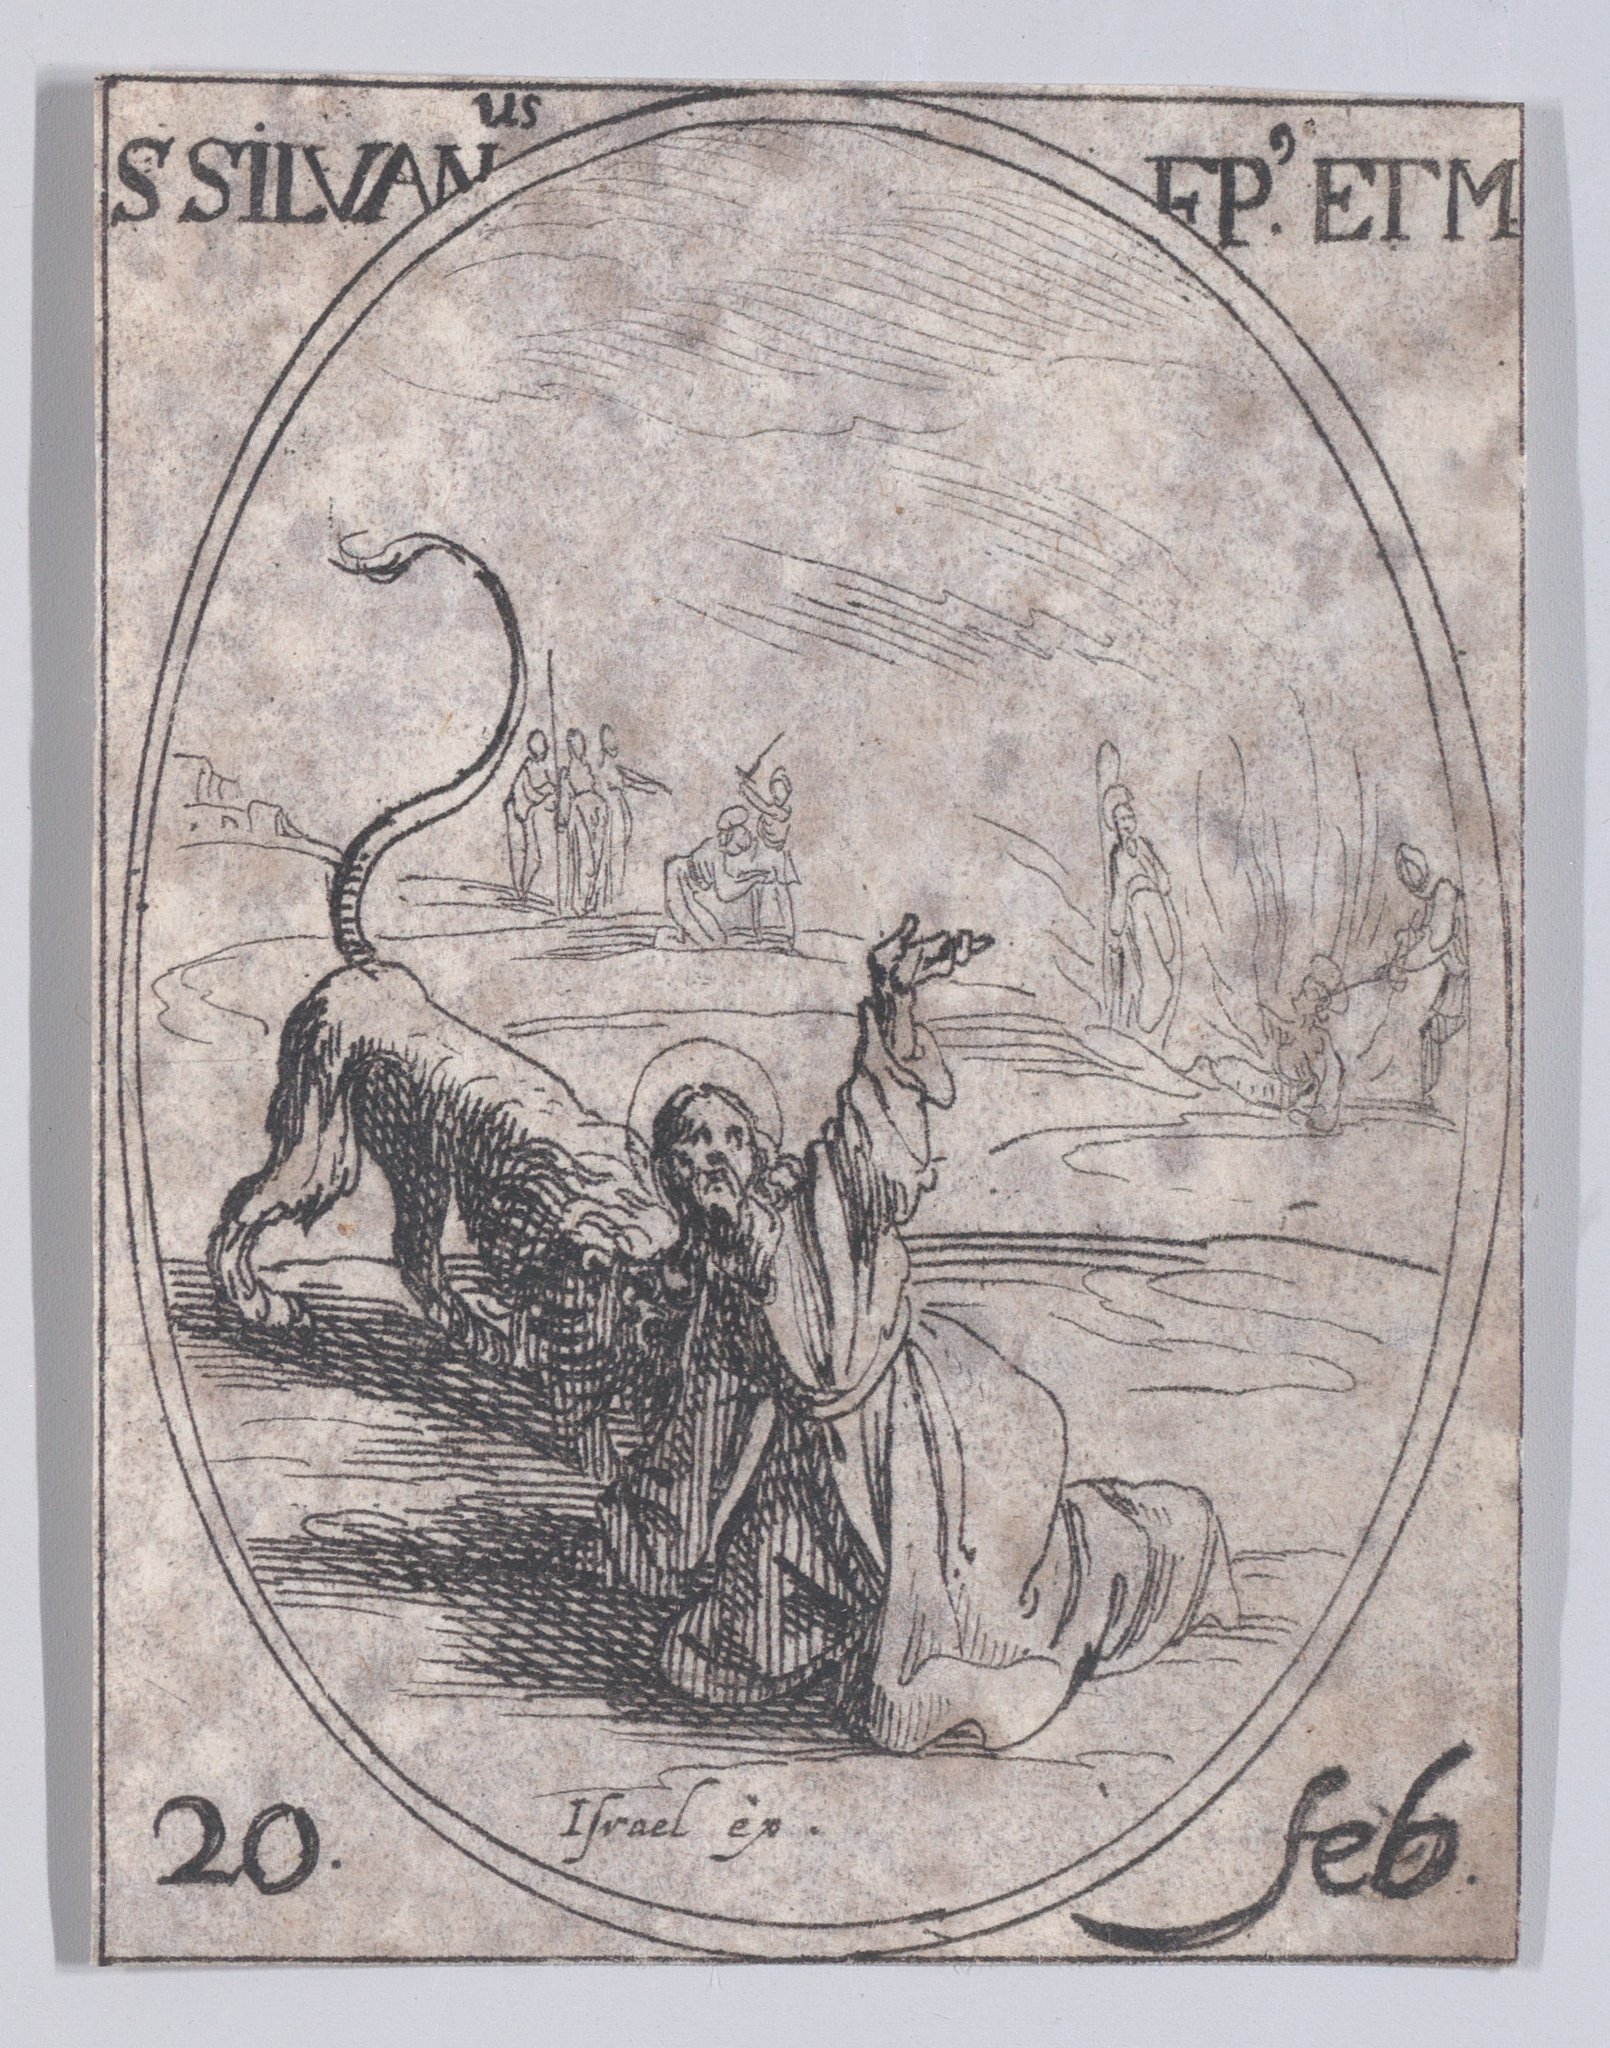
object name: print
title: S. Silvain, évêque et martyr (St. Sylvanus, Bishop and Martyr), February 20th, from "Les Images De Tous Les Saincts et Saintes de L'Année" (Images of All of the Saints and Religious Events of the Year)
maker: jacques callot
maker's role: artist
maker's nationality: french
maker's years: 1592-1635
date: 1636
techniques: etching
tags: men,lions,saints